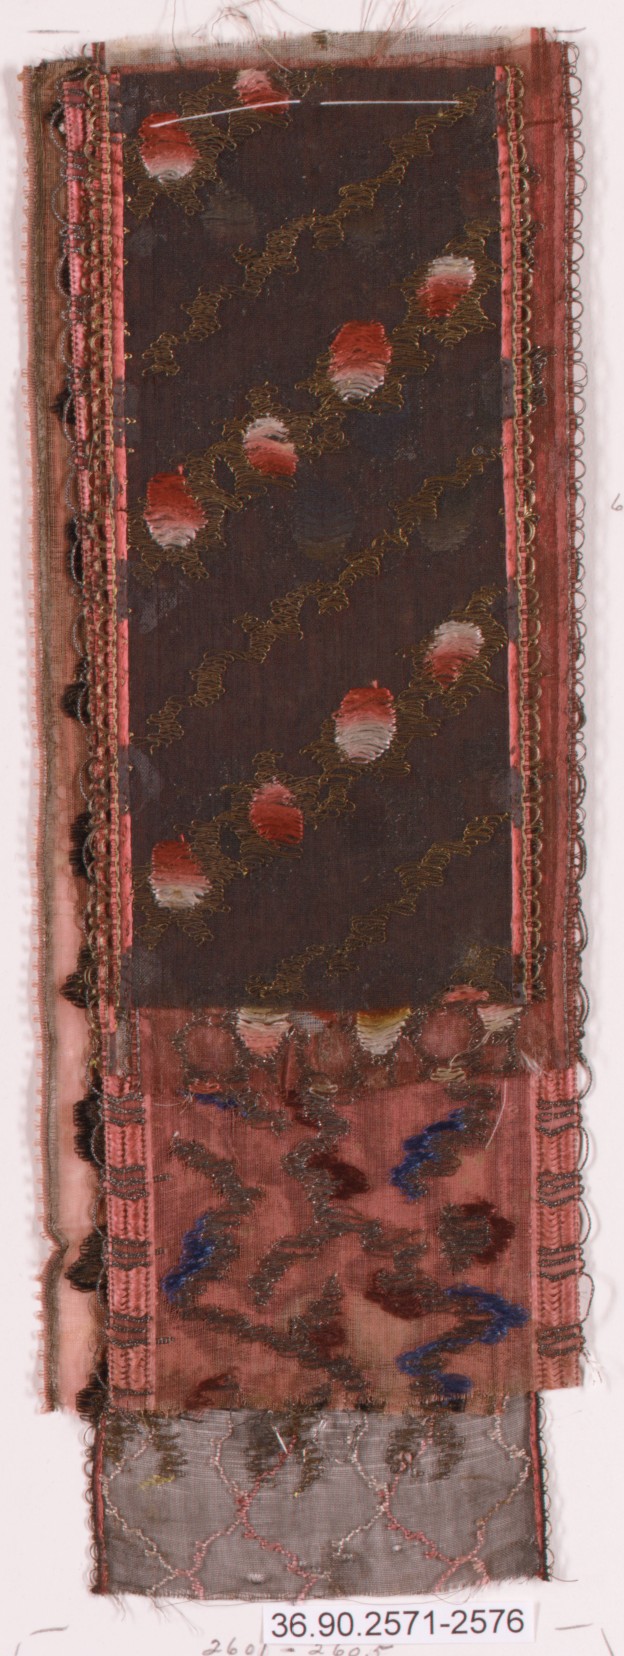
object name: ribbon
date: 1801-1900